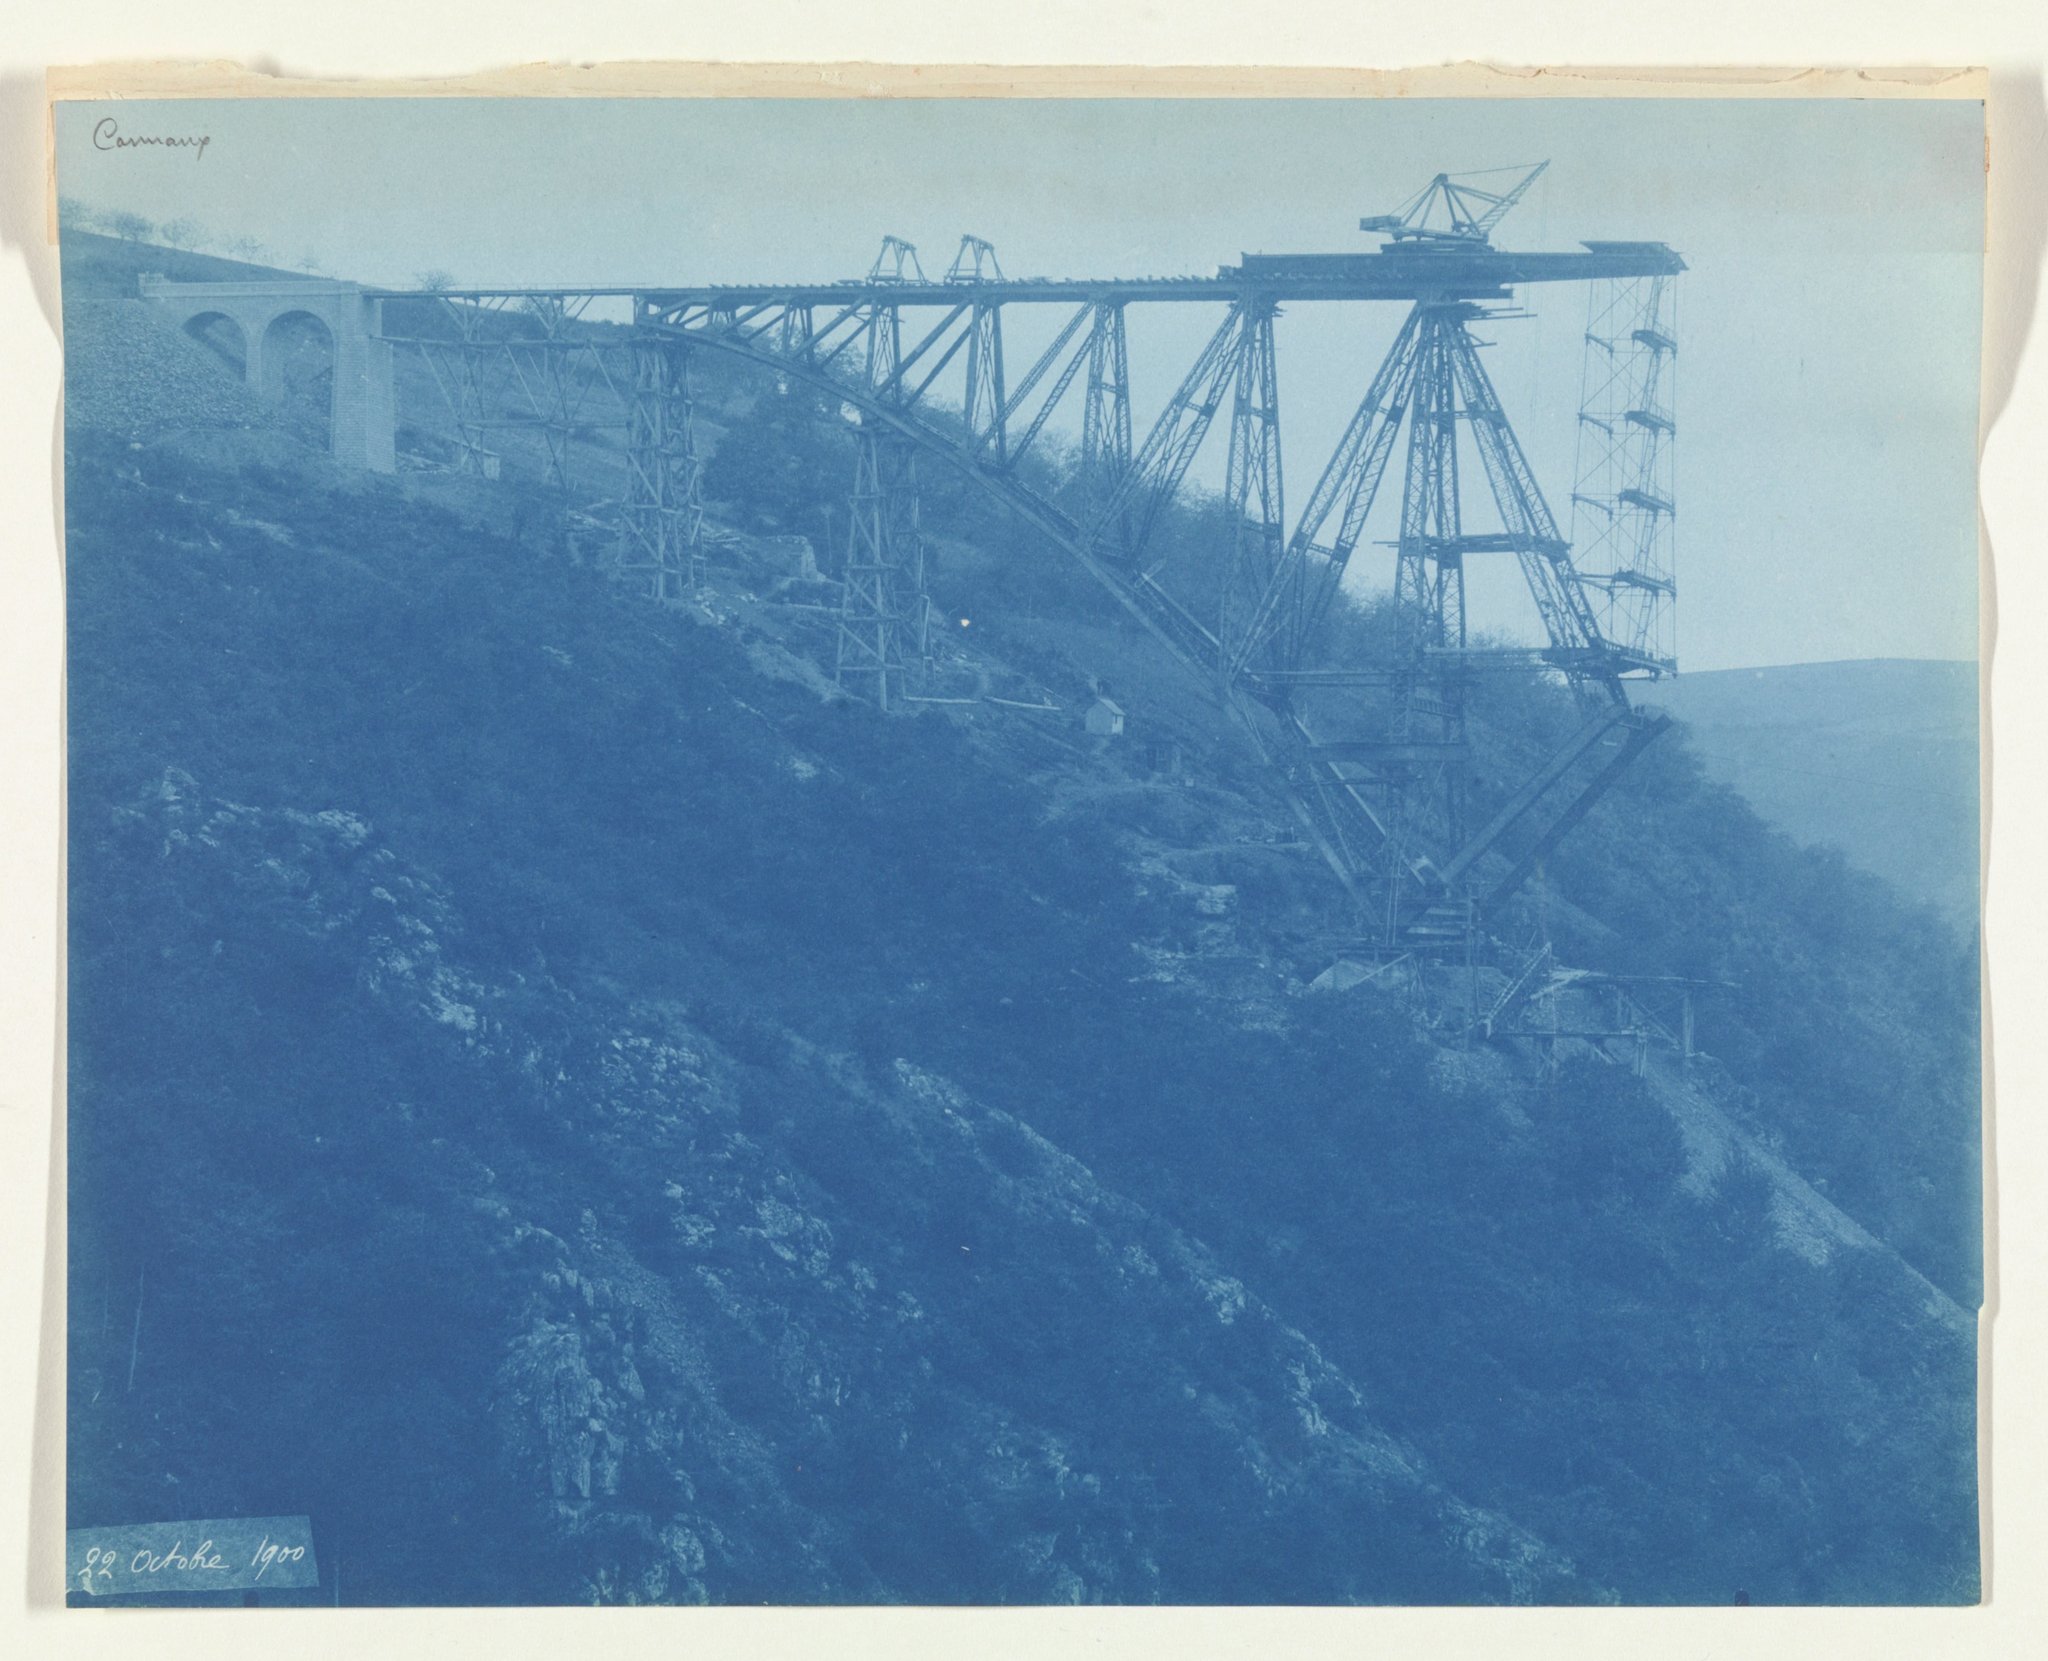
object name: photograph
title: Aanleg van het Viaur Viaduct in Frankrijk door de Societé de Construction des Battignolles, 22 oktober 1900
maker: Anonymous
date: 1900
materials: photographic support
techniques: cyanotype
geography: france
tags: viaduct, making the overground structures (~ building activities)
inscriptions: inscription: ‘Carmaux’